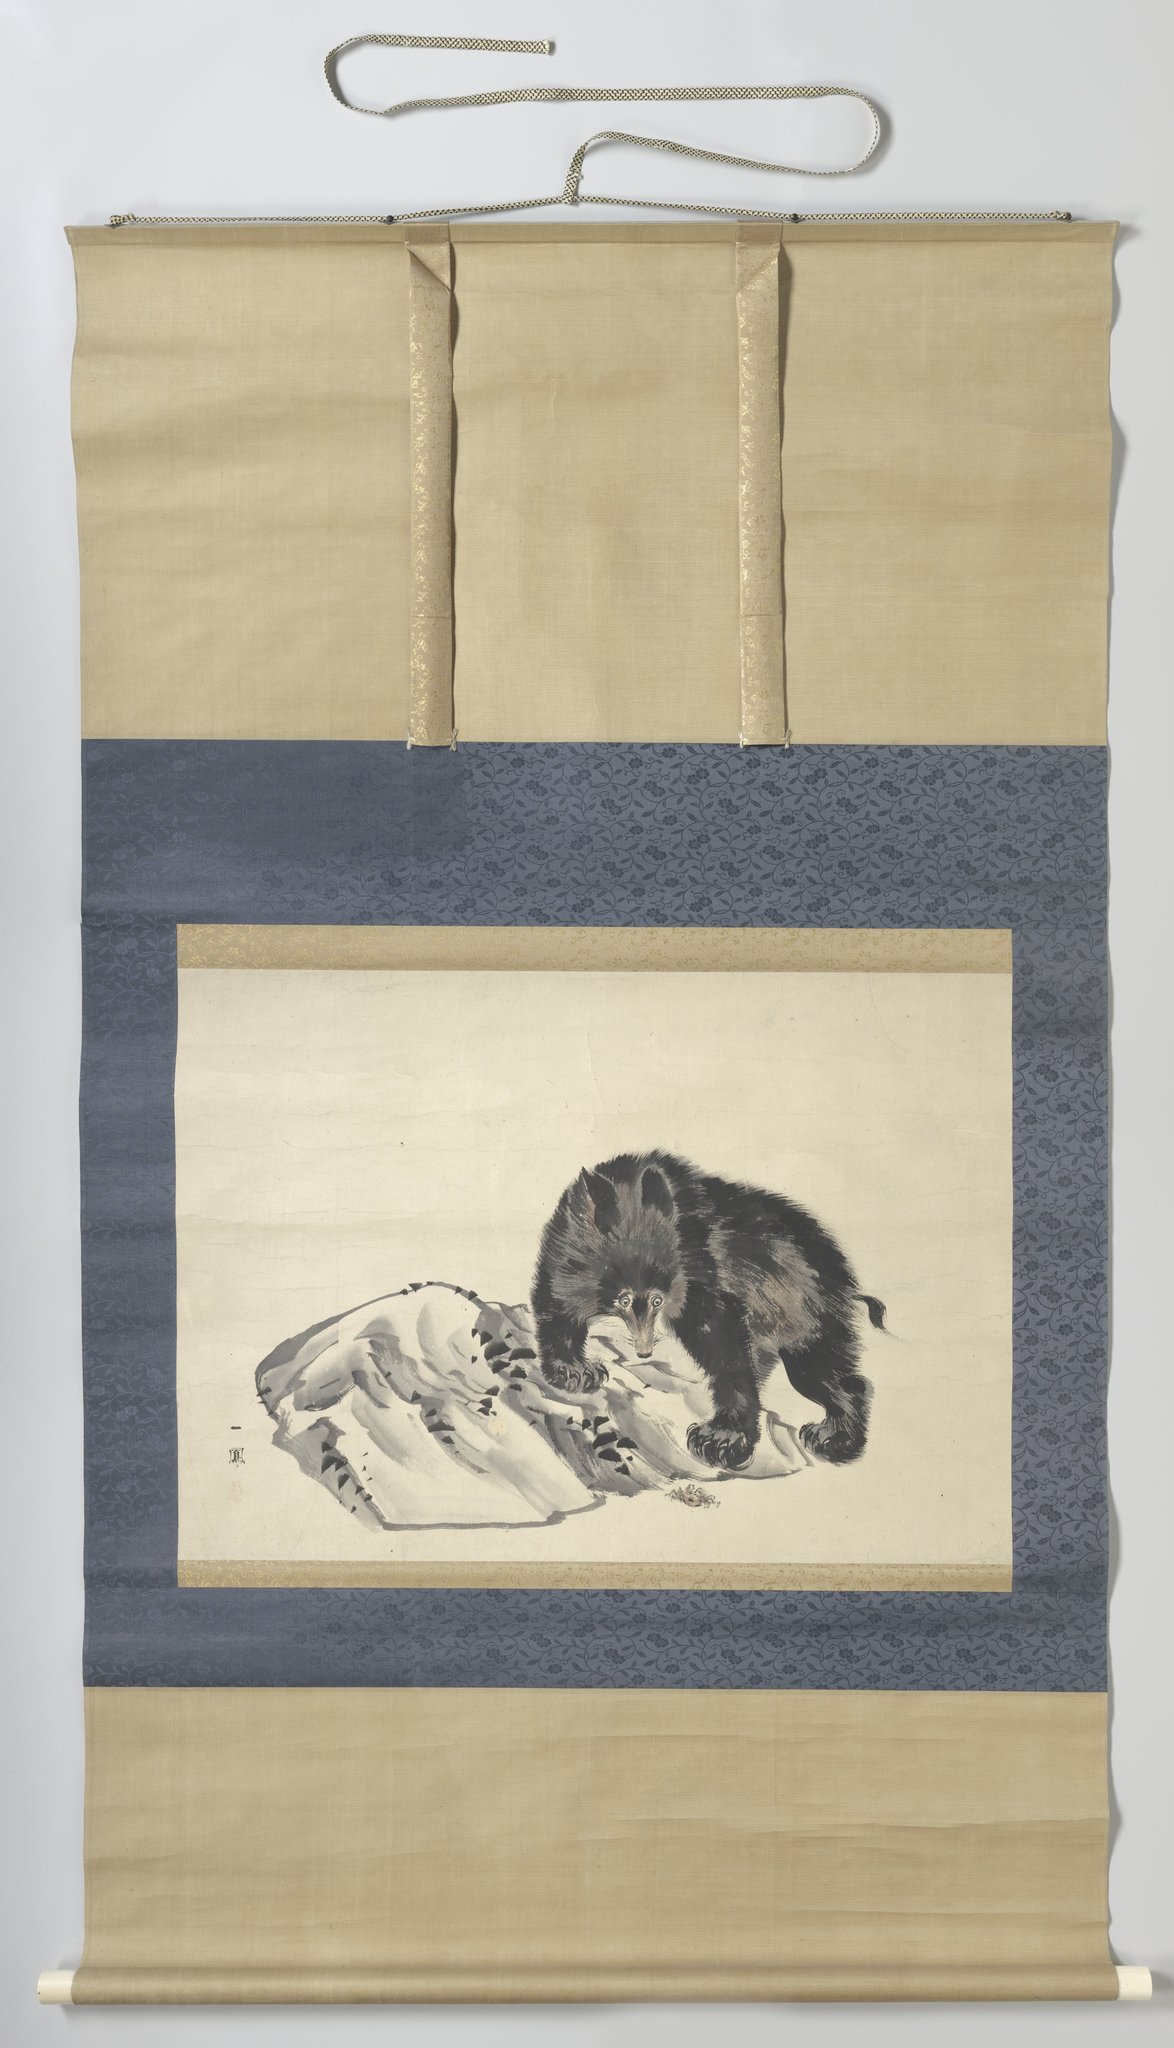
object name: hanging scroll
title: Bear and Crab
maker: mori ippô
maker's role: draughtsman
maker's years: 1798-1871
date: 1808-1871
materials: ink, paint, paper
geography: japan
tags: beasts of prey, predatory animals: bear, crustaceans: crab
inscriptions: signature, seal, label, box: ‘Mori Ippo’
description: Just like Sosen, Ippo strove to express the essence of animals in ink. He made an interesting composition juxtaposing the large bear with the small crab and the pale rock with the dark bear. The interaction between the animals provides a cheerful note. This kind of visually creative work was in great demand in Kyoto’s art market.